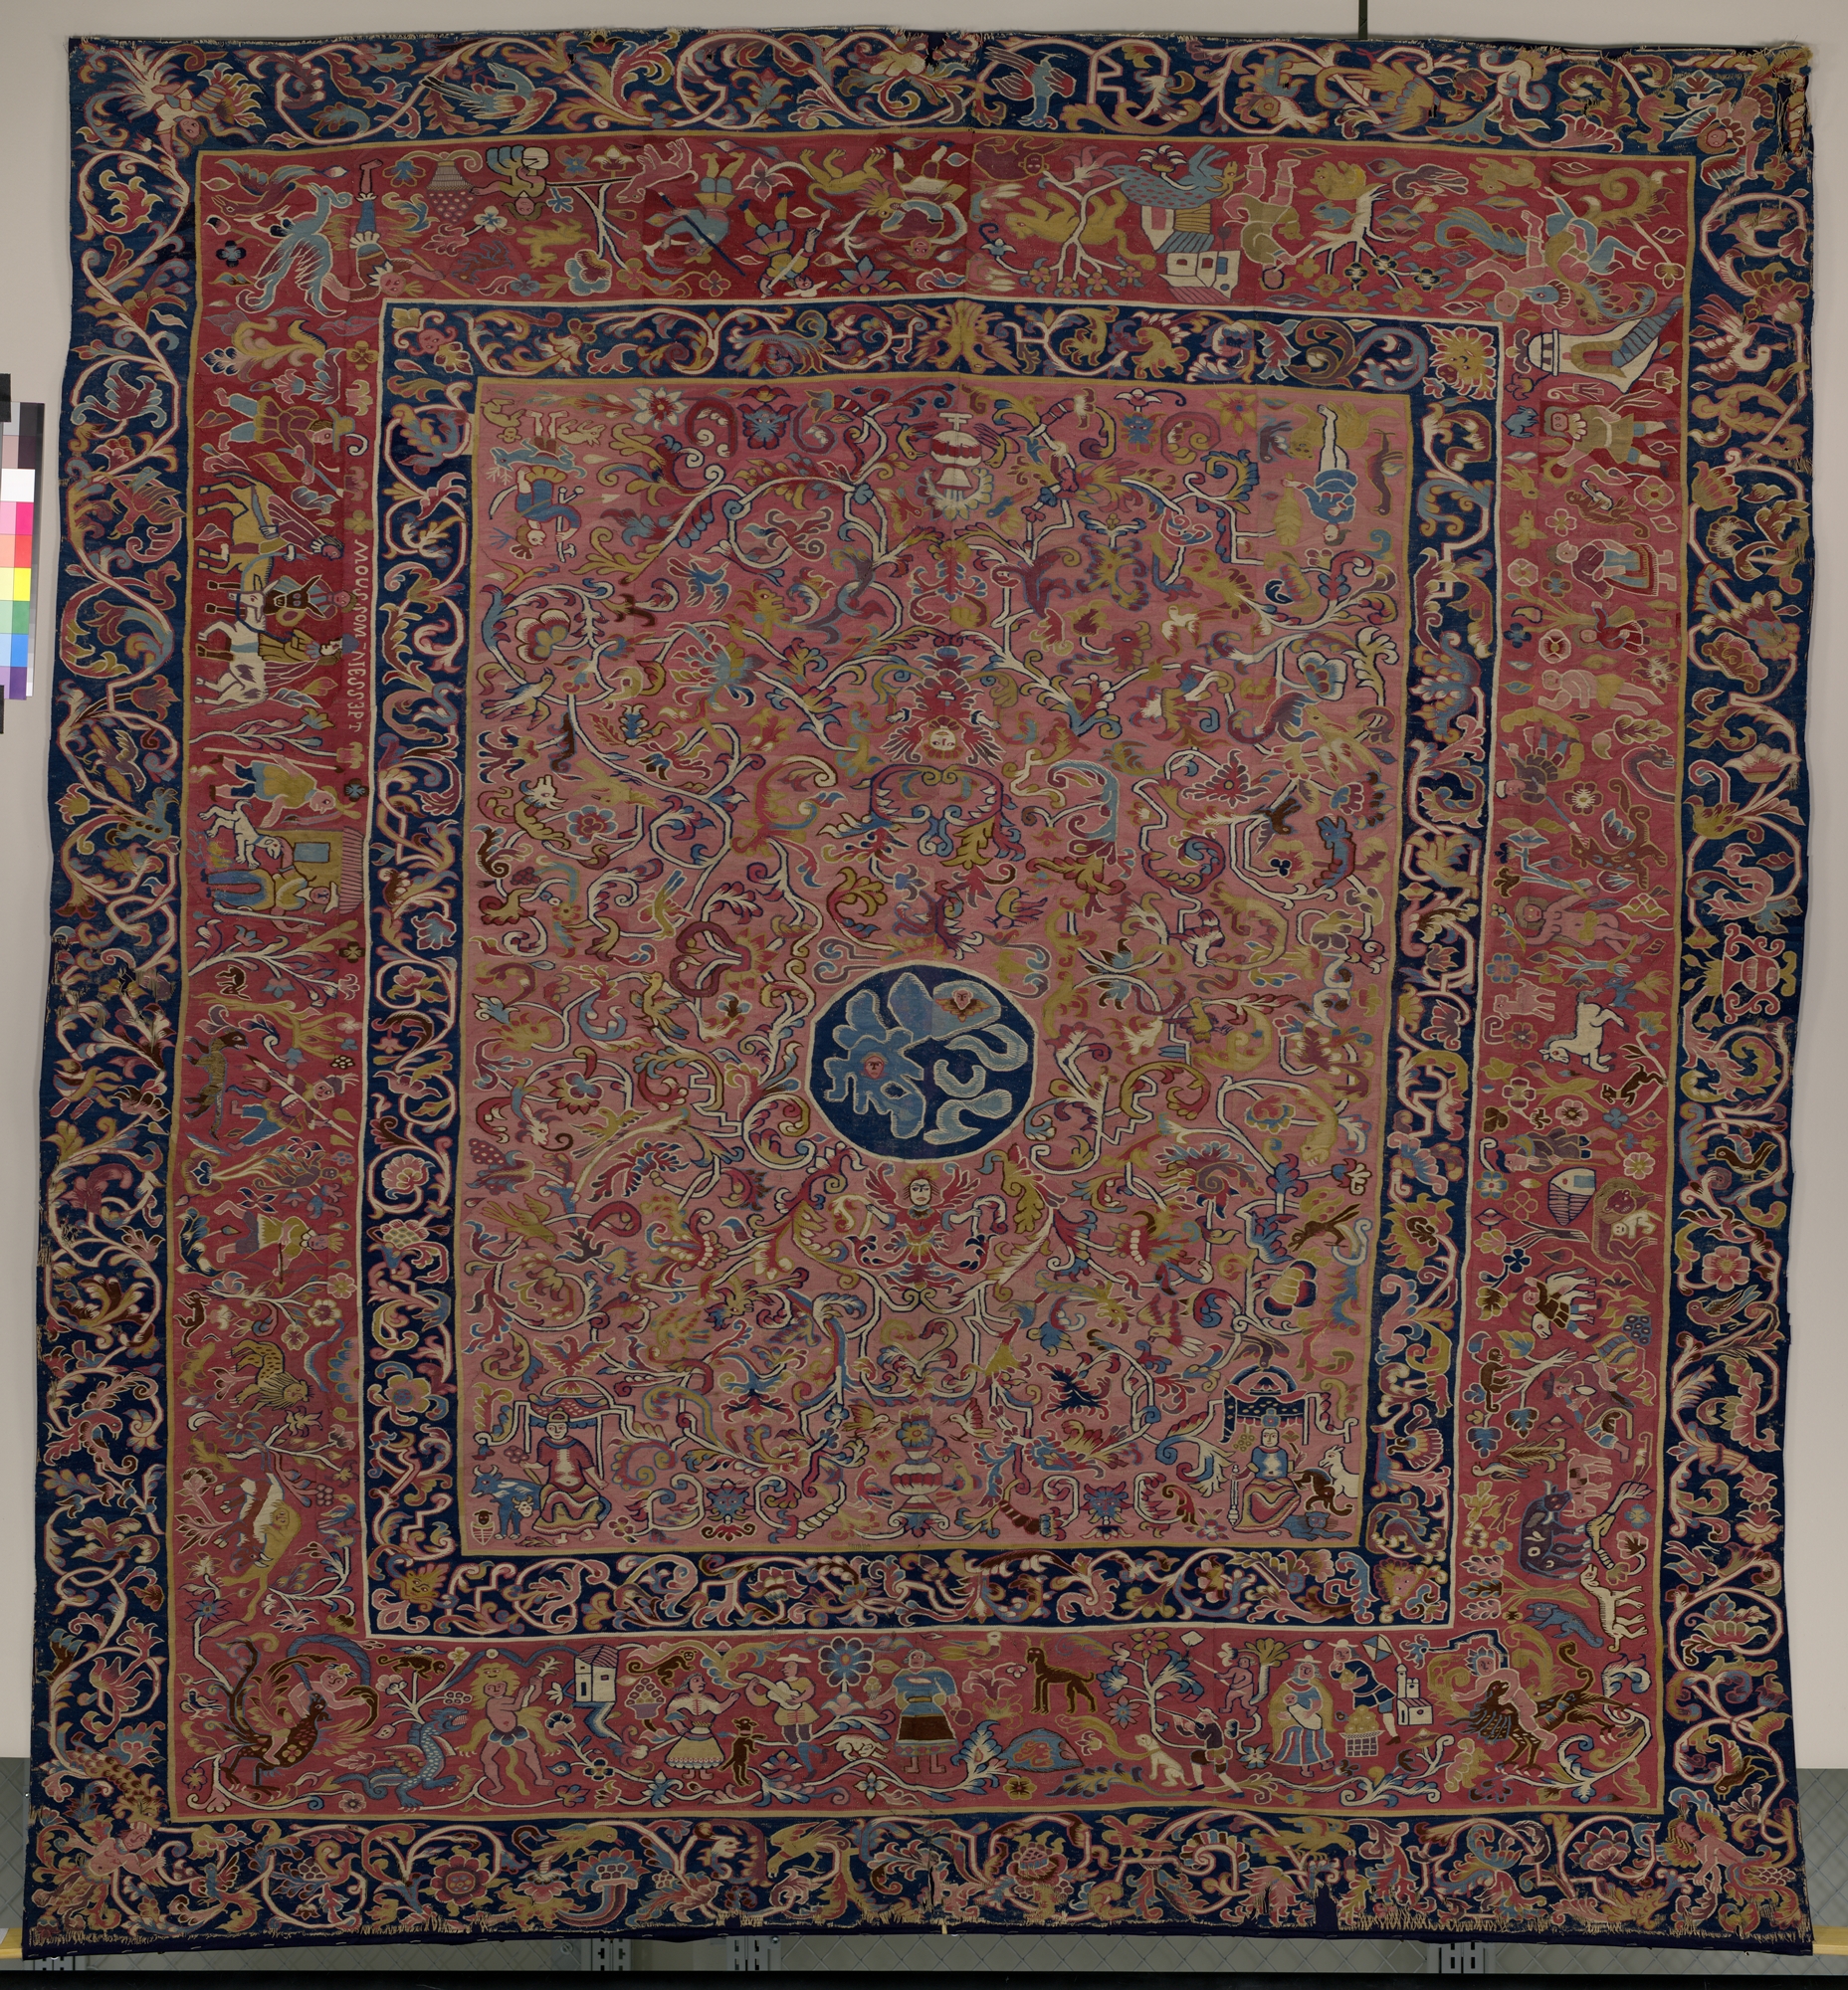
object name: tapestry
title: Tapestry with figurative scenes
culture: peruvian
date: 1601-1700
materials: animal fiber, cotton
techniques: weave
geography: peru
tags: animals,birds,men,women,dragons,dogs